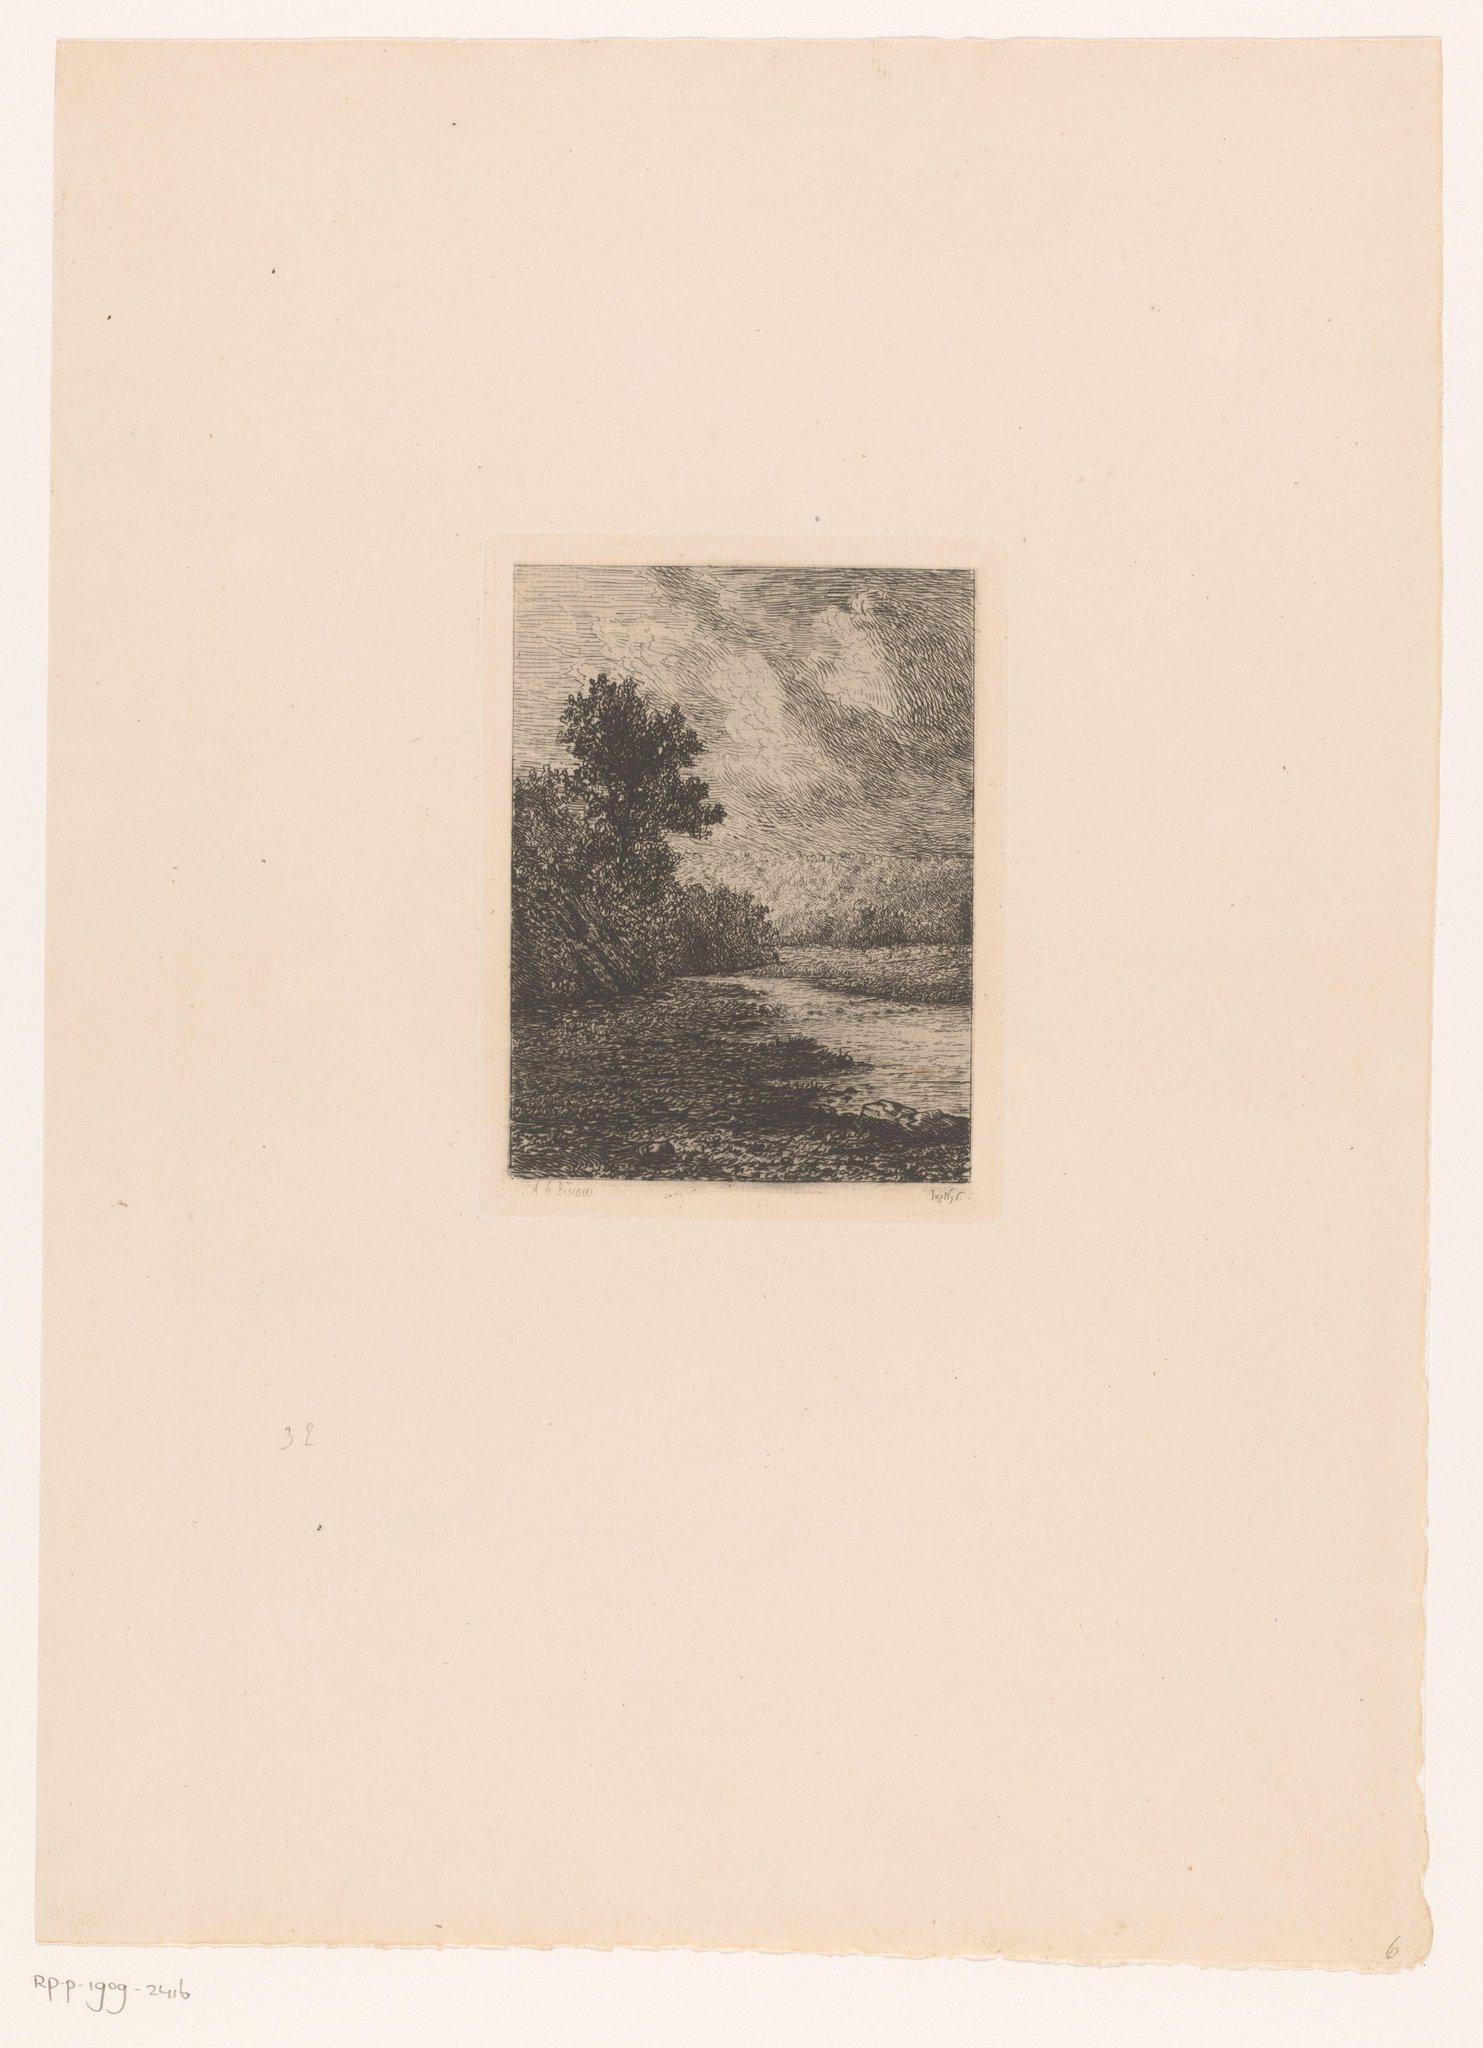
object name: print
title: Rivierlandschap bij maanlicht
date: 1854-1883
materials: paper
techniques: drypoint, etching, intaglio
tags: river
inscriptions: collector's mark: Lugt 2228